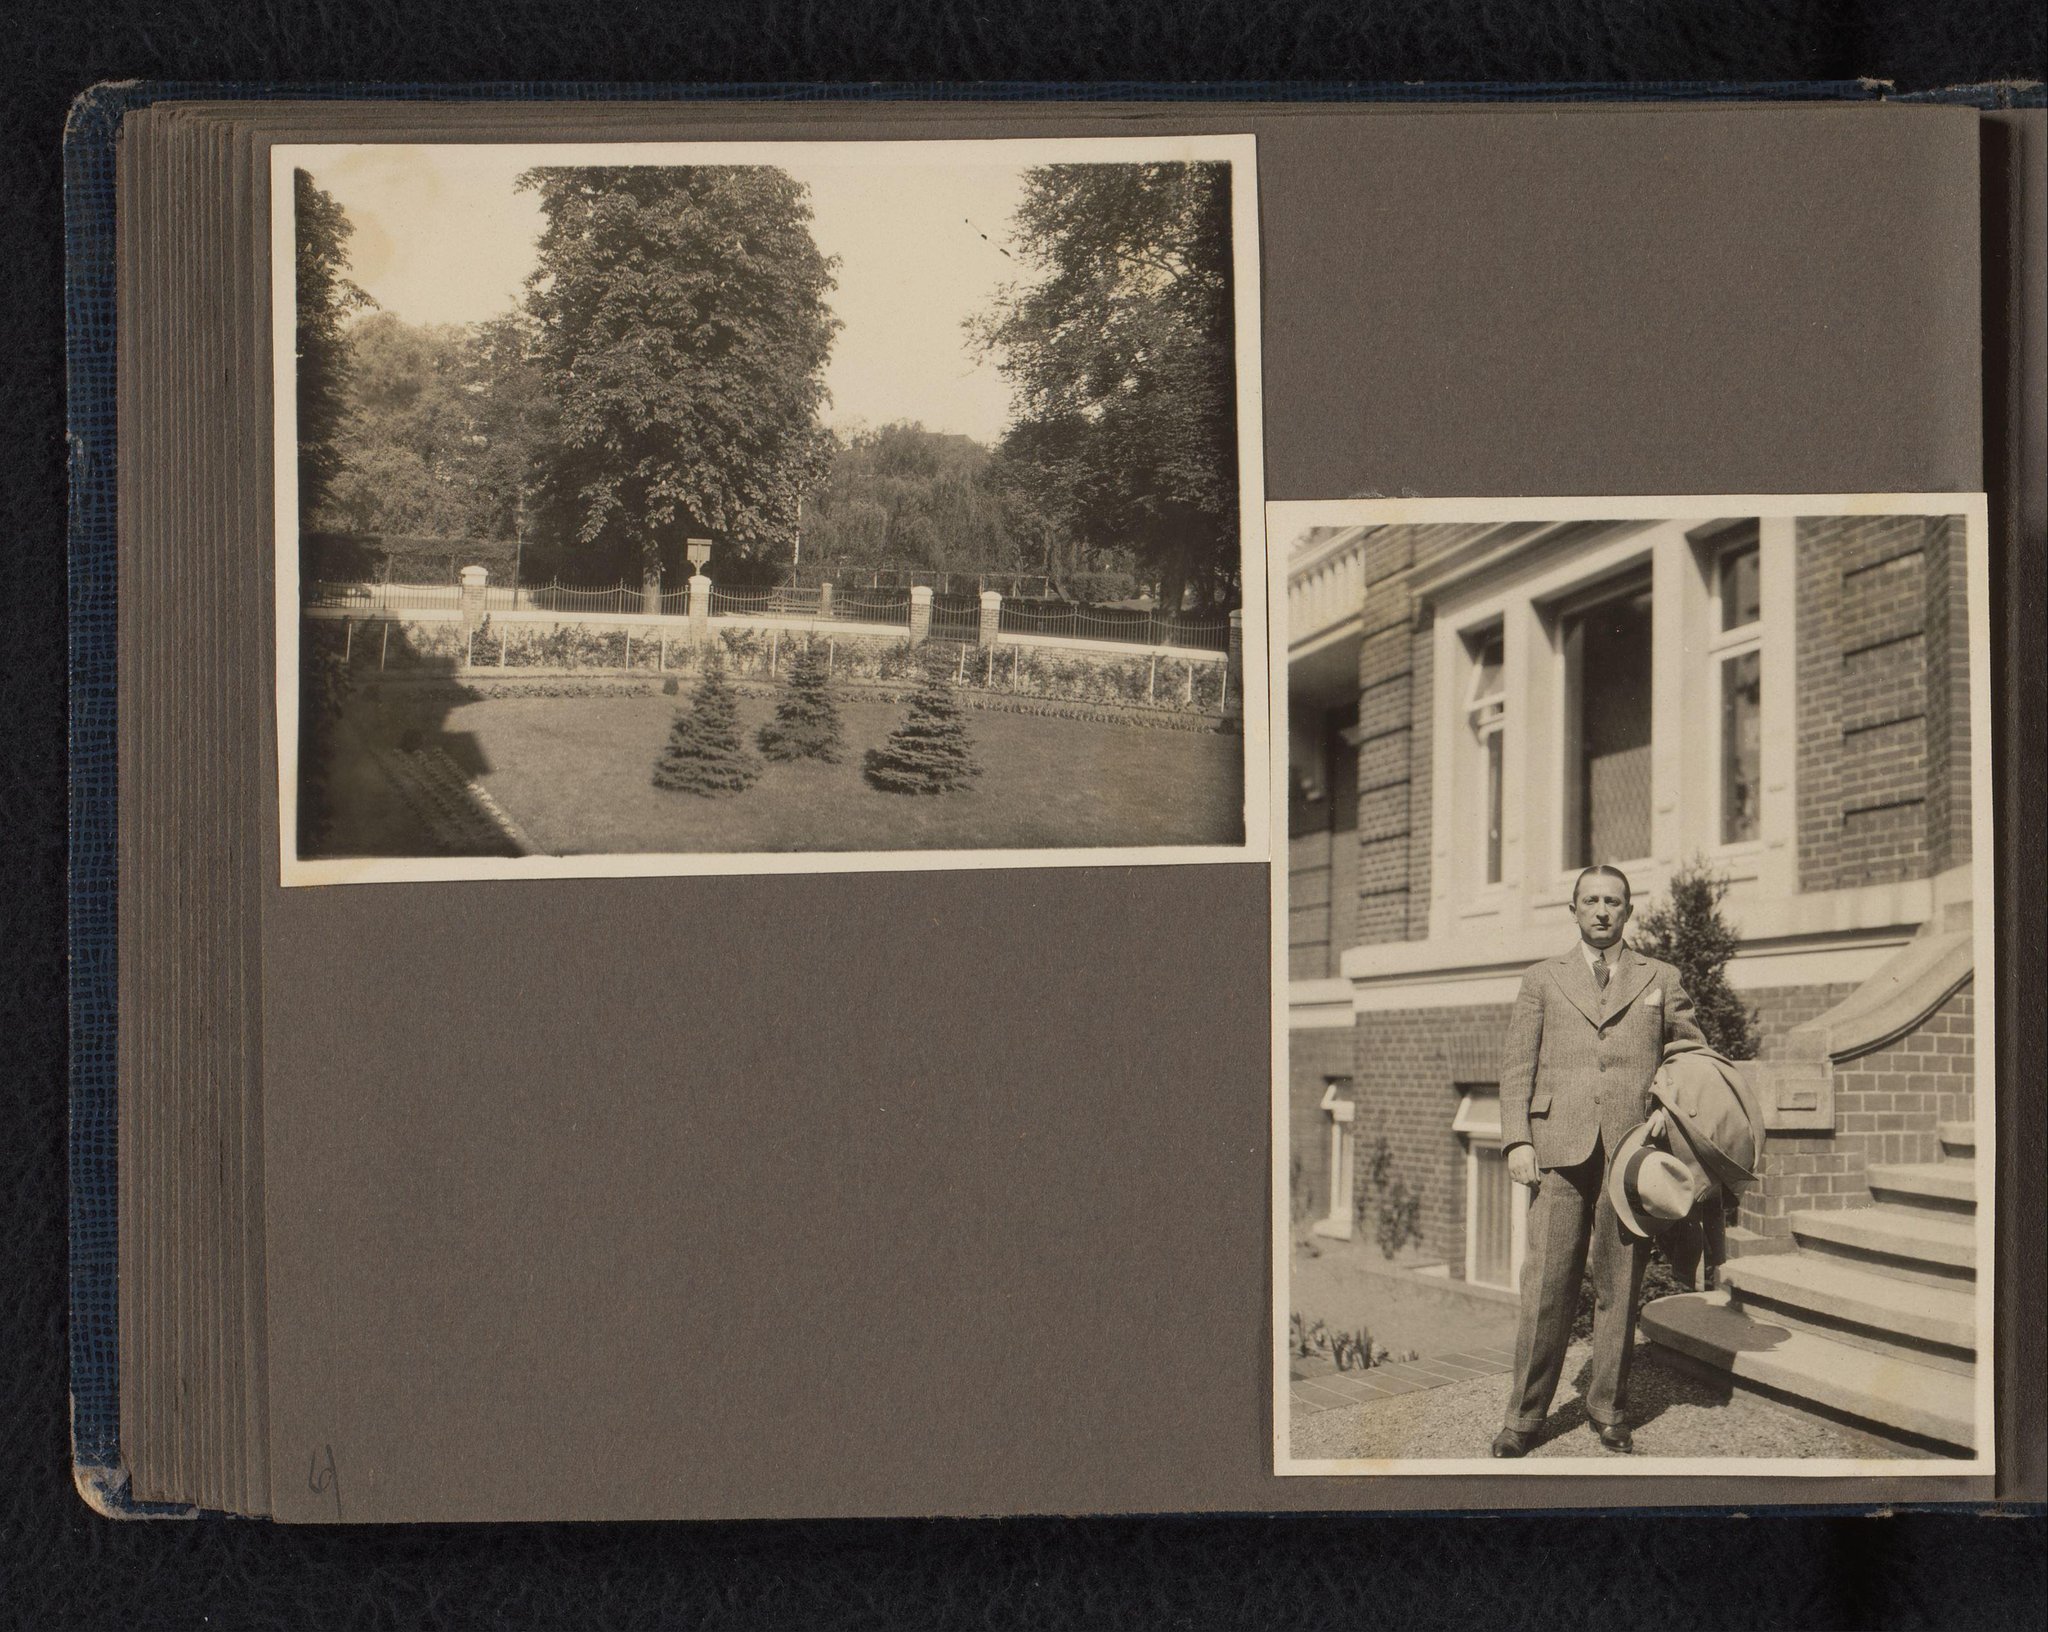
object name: photograph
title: Tuin en woning van Willy Moos en Willy in zijn tuin (Bellevue 62), vermoedelijk 1928, Hamburg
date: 1928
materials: paper, photographic support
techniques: gelatin silver print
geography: hamburg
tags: willy moos, backyard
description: Albumblad bevat twee foto's van Willy Moos. Uit album half formaat, blauw kunstlederen omslag met koordbinding.